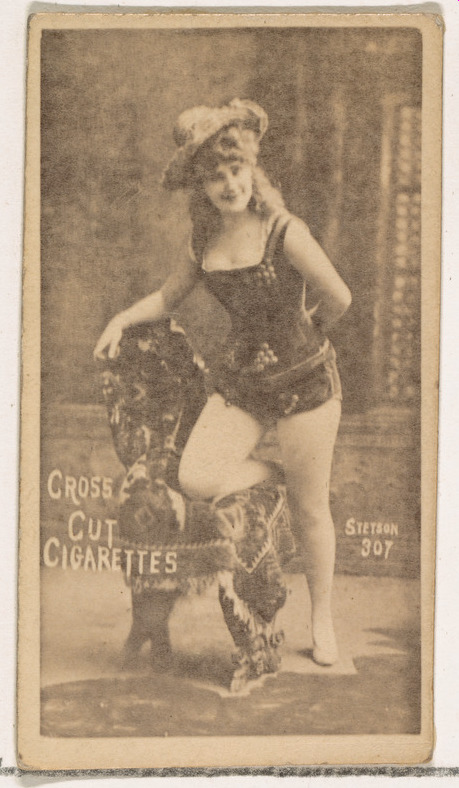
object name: print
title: Card Number 307, Stetson, from the Actors and Actresses series (N145-1) issued by Duke Sons & Co. to promote Cross Cut Cigarettes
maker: w. duke, sons & co.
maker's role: publisher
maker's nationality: american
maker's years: 1870-1920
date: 1880-1889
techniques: albumen silver print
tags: portraits,women,actresses